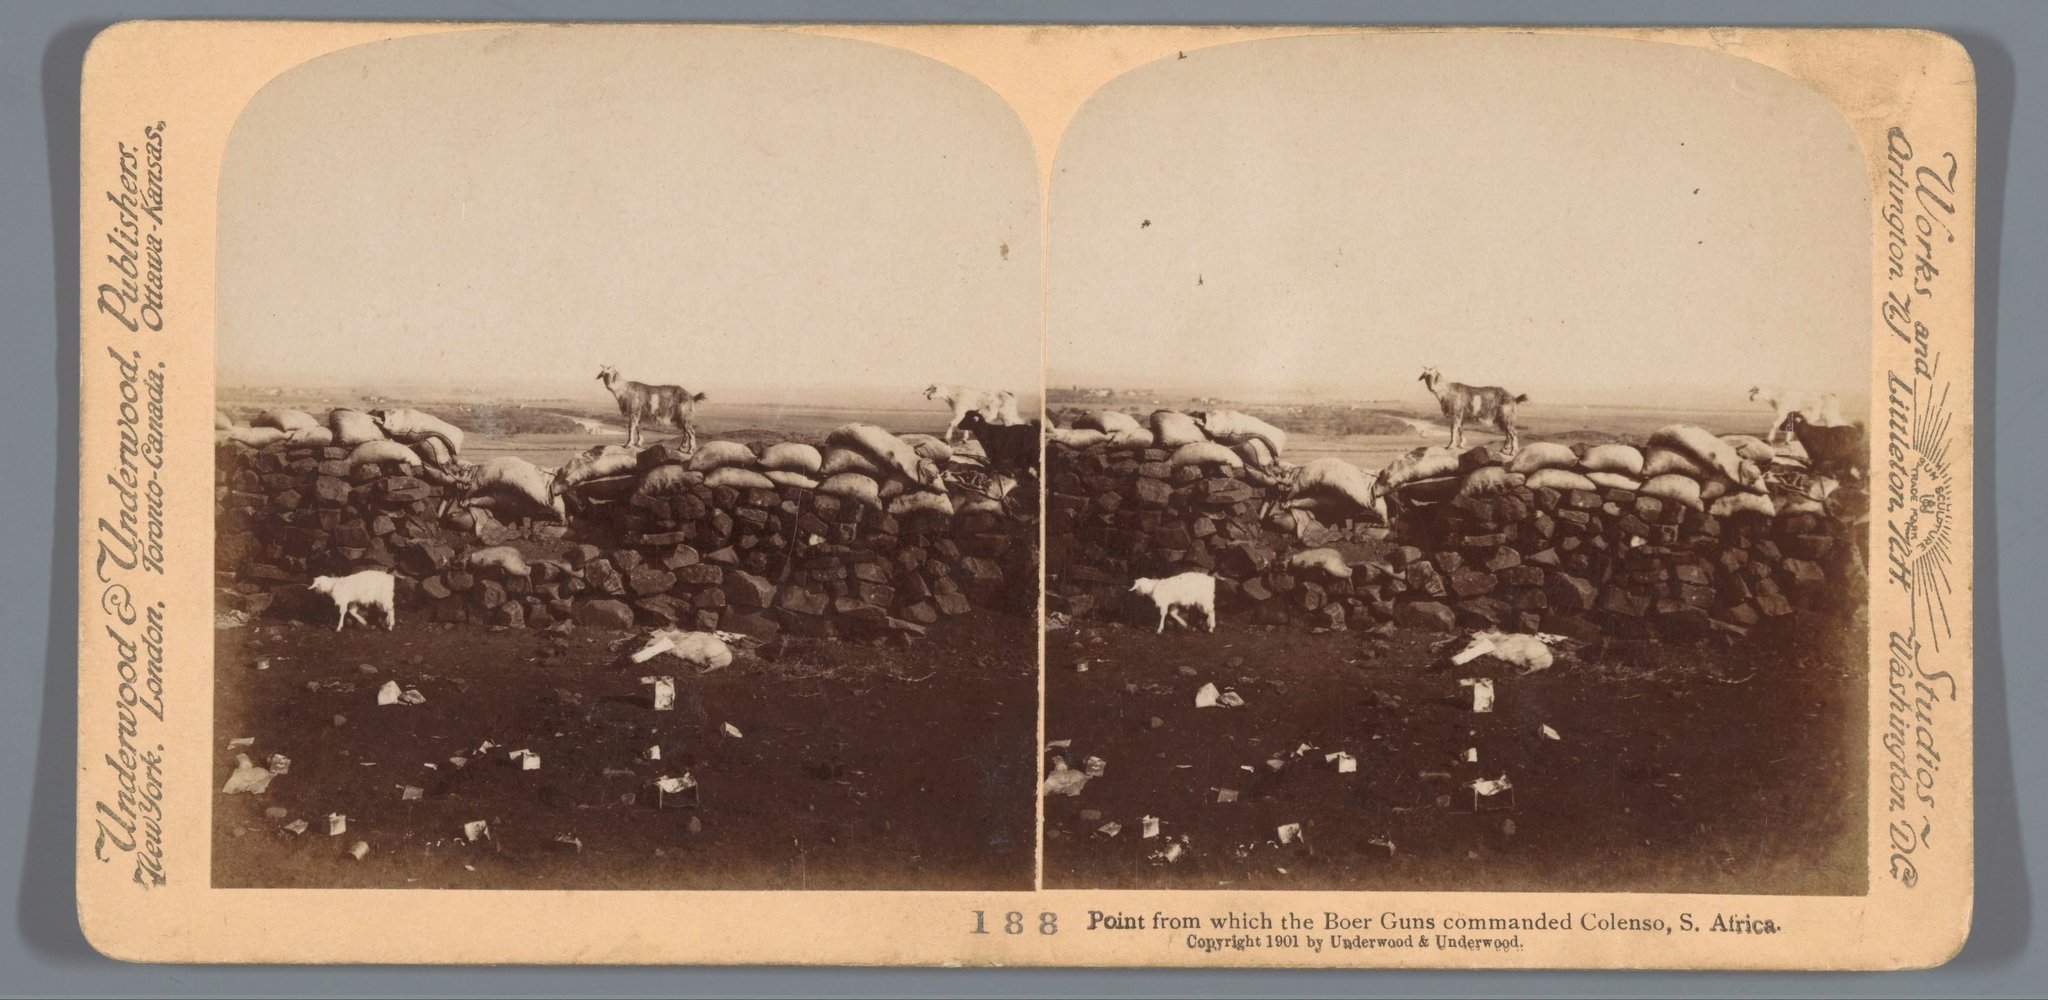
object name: stereograph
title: Gezicht op een muur met zandzakken en geiten, vanaf hier is gevochten tijdens de Tweede Boerenoorlog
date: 1901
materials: cardboard, photographic support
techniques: albumen print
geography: south africa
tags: battle, goat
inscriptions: number: ‘188’, name: ‘Works and Studios Sun Sculpture trade mark Arlington N.J. Littleton N.H. Washington D.C.’